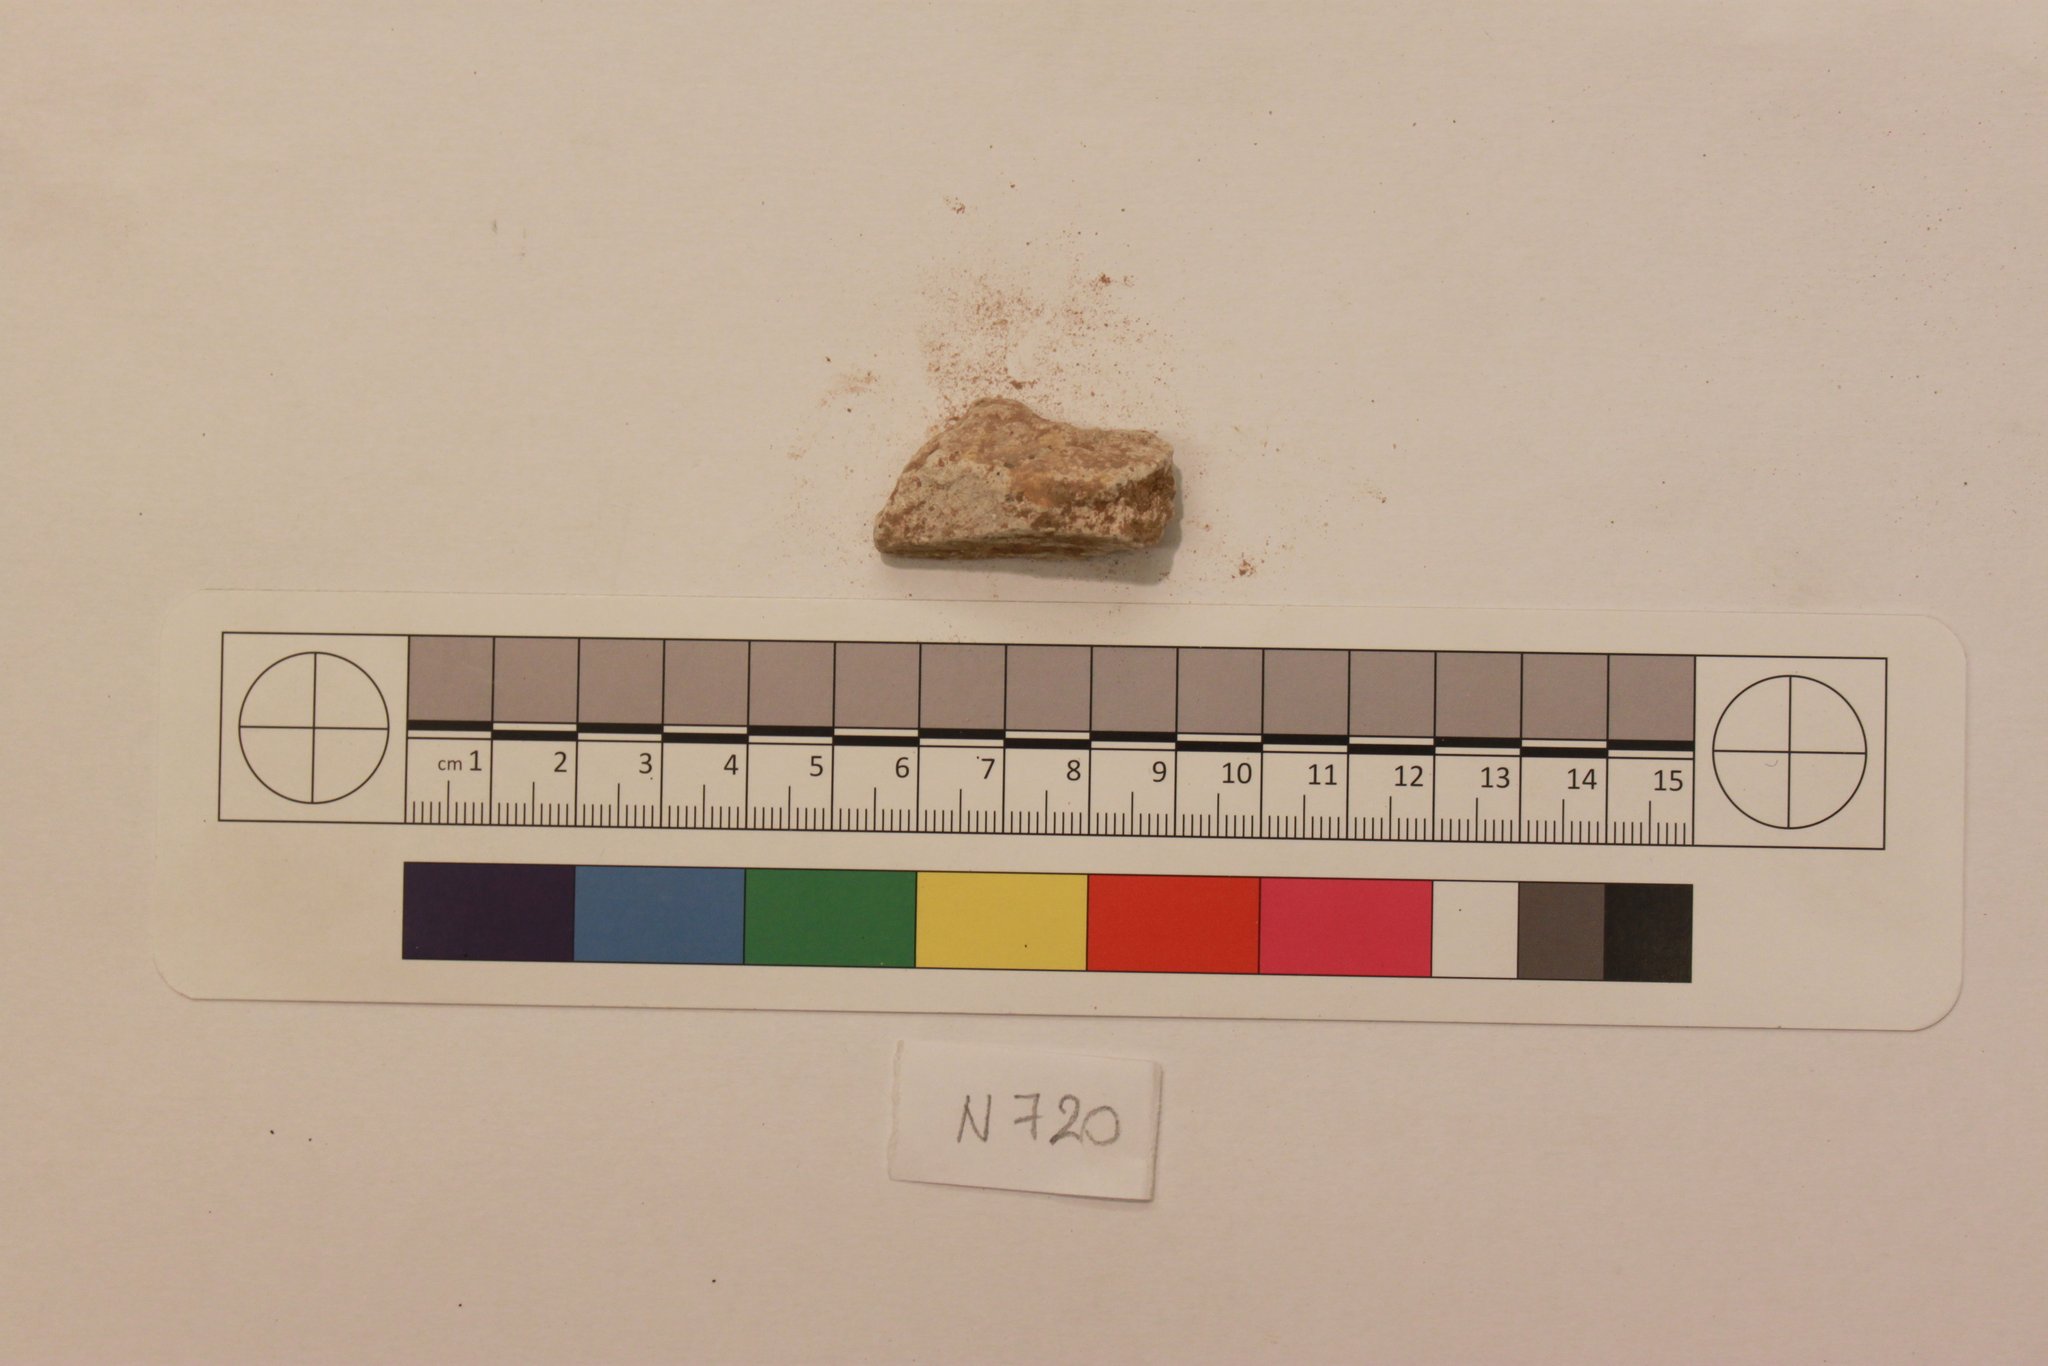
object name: fragment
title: Stucco Fragment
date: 701-1200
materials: plaster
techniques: carving, painting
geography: iran